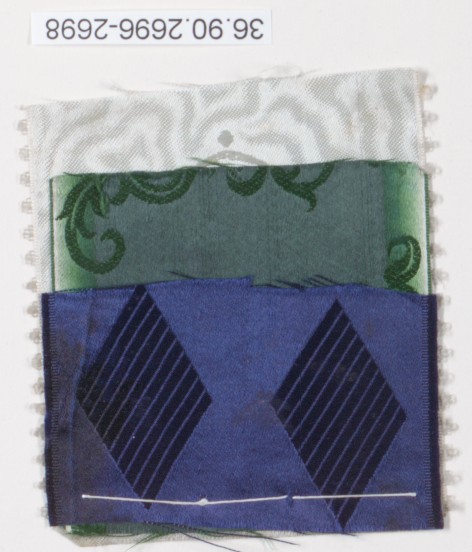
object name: ribbon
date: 1801-1900